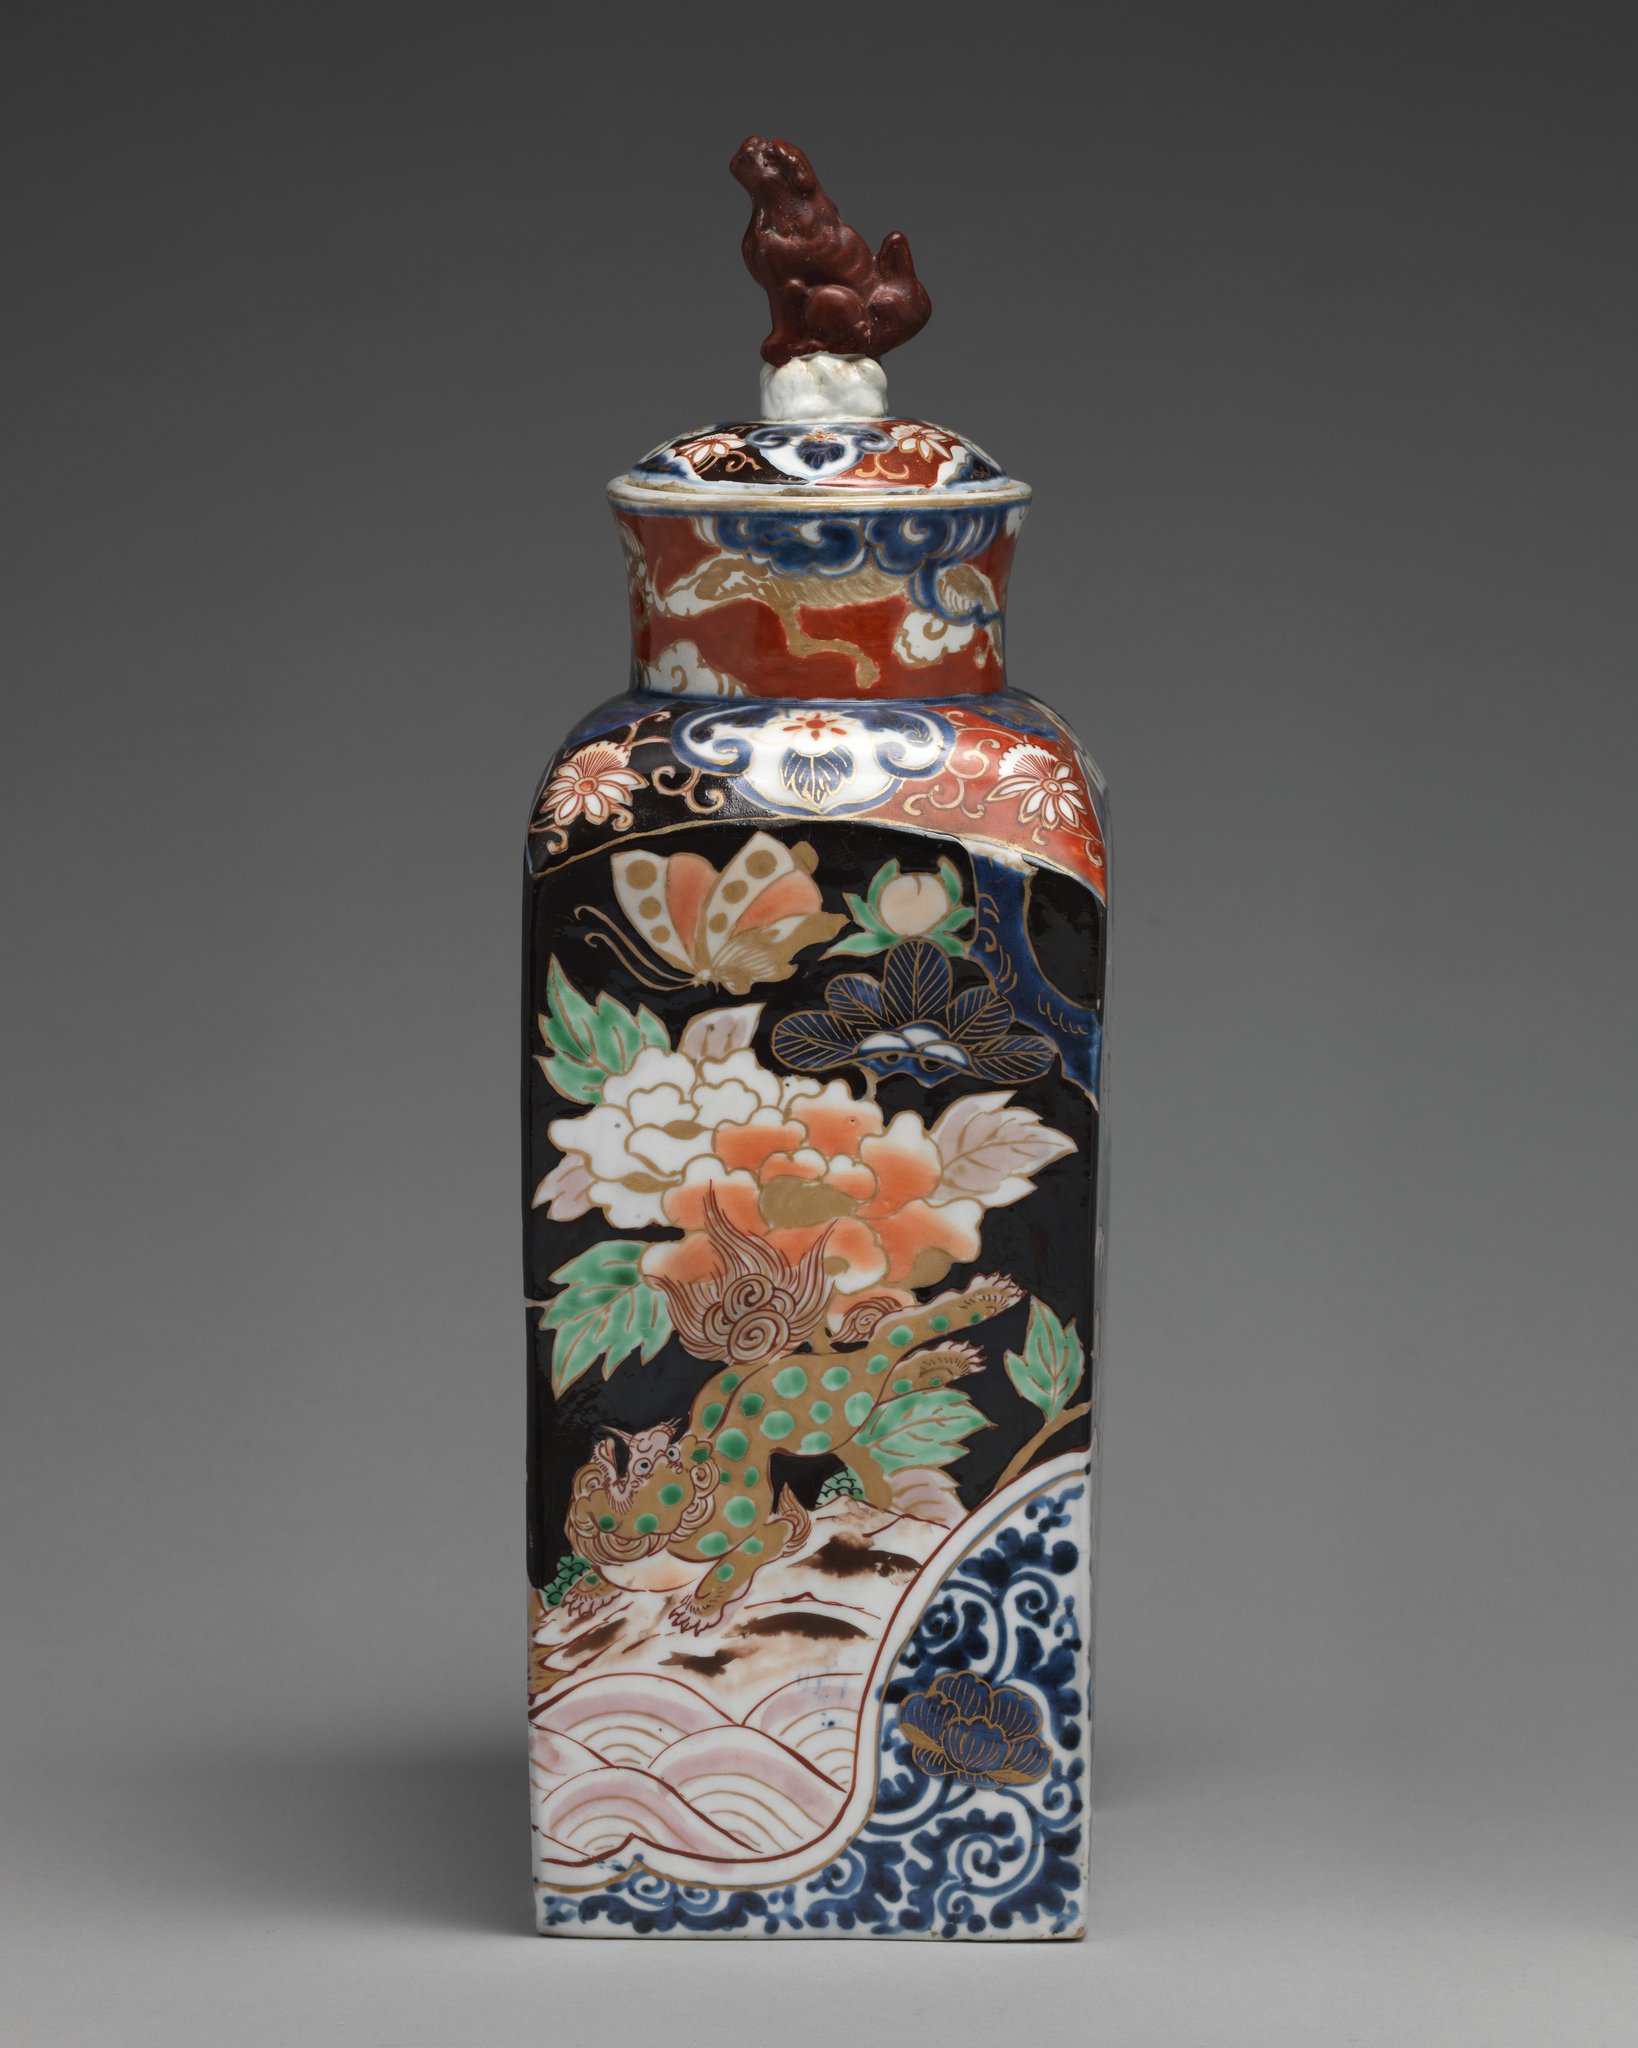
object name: bottle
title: Square bottle with stopper (one of a pair)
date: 1690-1720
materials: enamel, hard paste porcelain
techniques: gilding, overglaze, underglaze